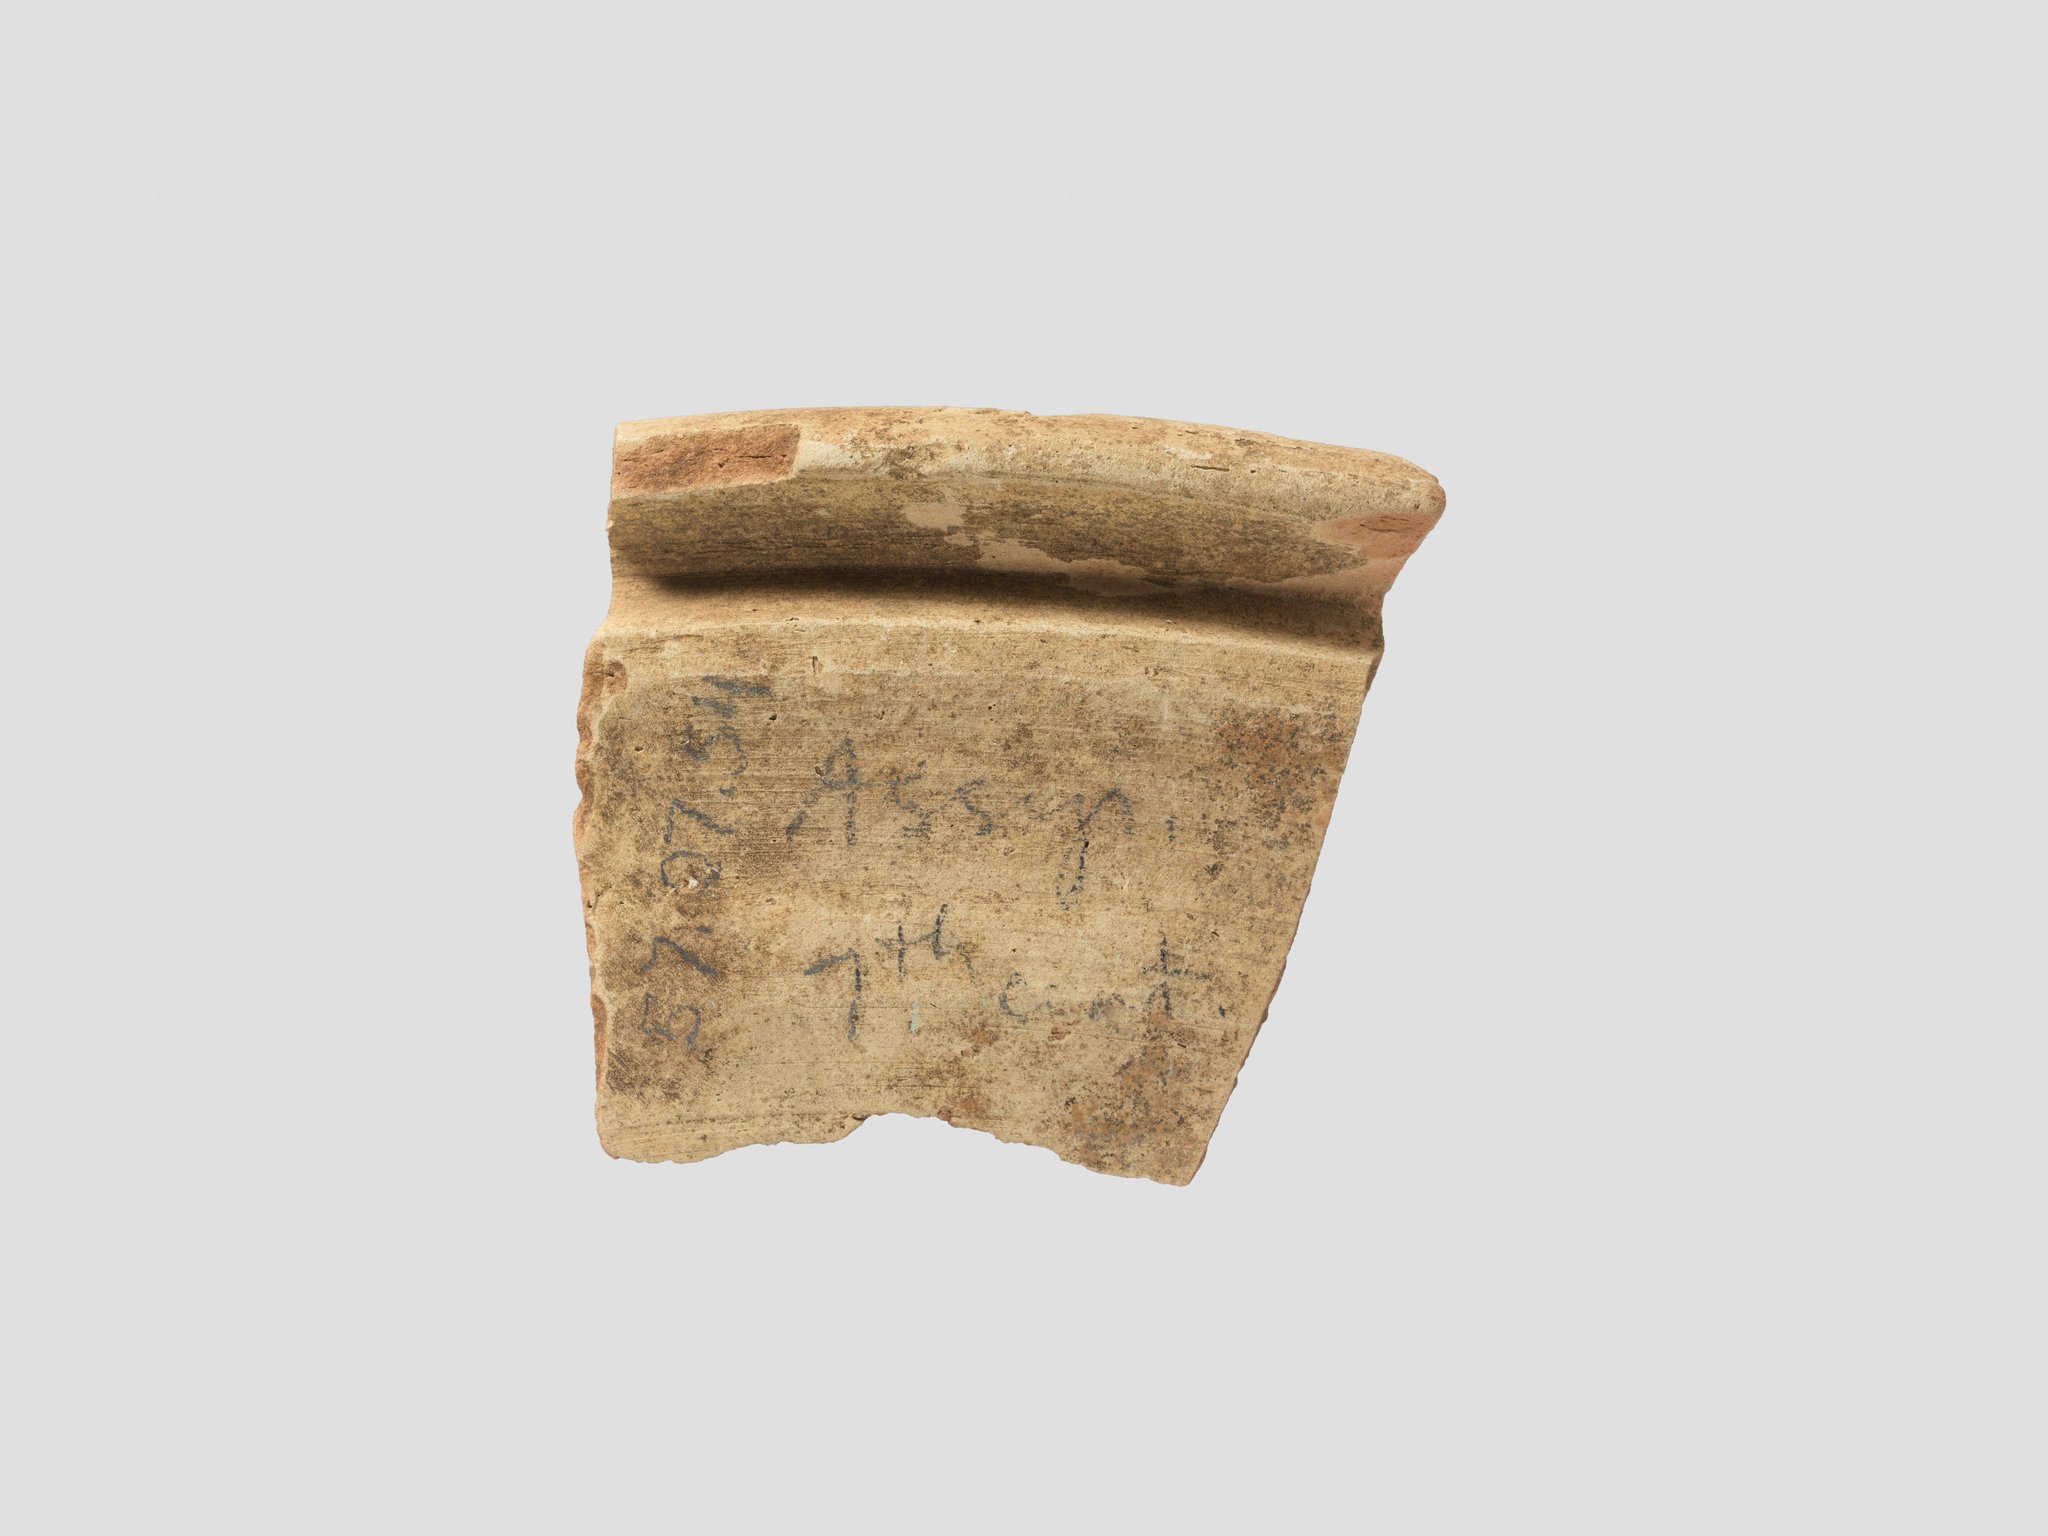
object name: sherd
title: Rim sherd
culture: assyrian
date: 800-601 BCE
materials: ceramic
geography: mesopotamia